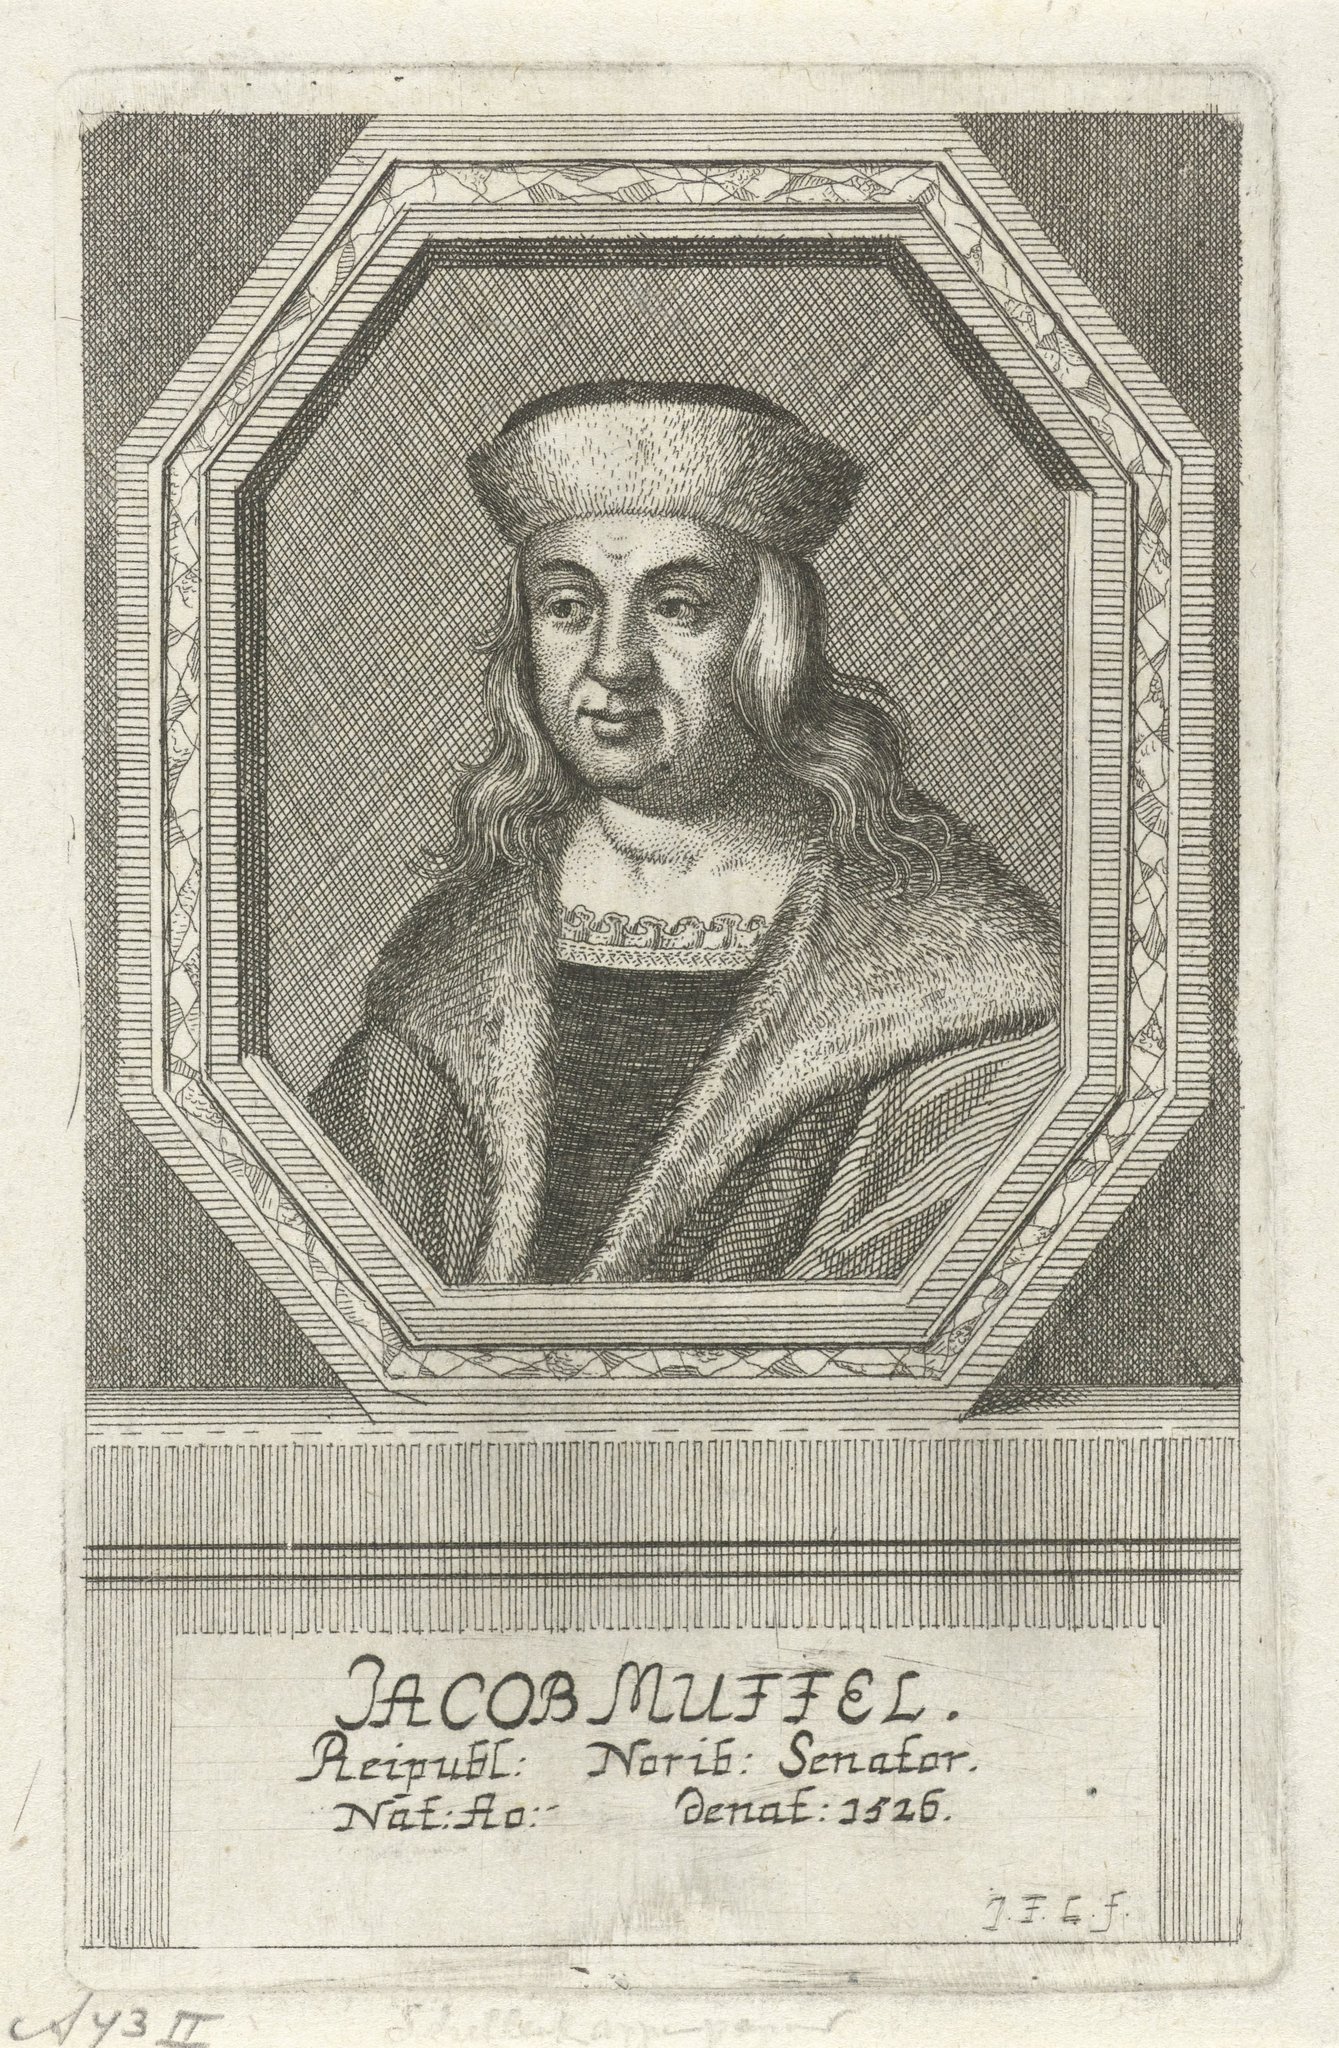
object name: print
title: Portret van Jacob Muffel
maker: johann friedrich leonard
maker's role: print maker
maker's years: 1633-1680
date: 1643-1680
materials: paper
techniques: engraving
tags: senator, jacob muffel (1471-1526)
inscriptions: collector's mark: Lugt 2228, collector's mark: Lugt 1337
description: Portret van Jacob Muffel (1471-1526), senator te Neurenberg.